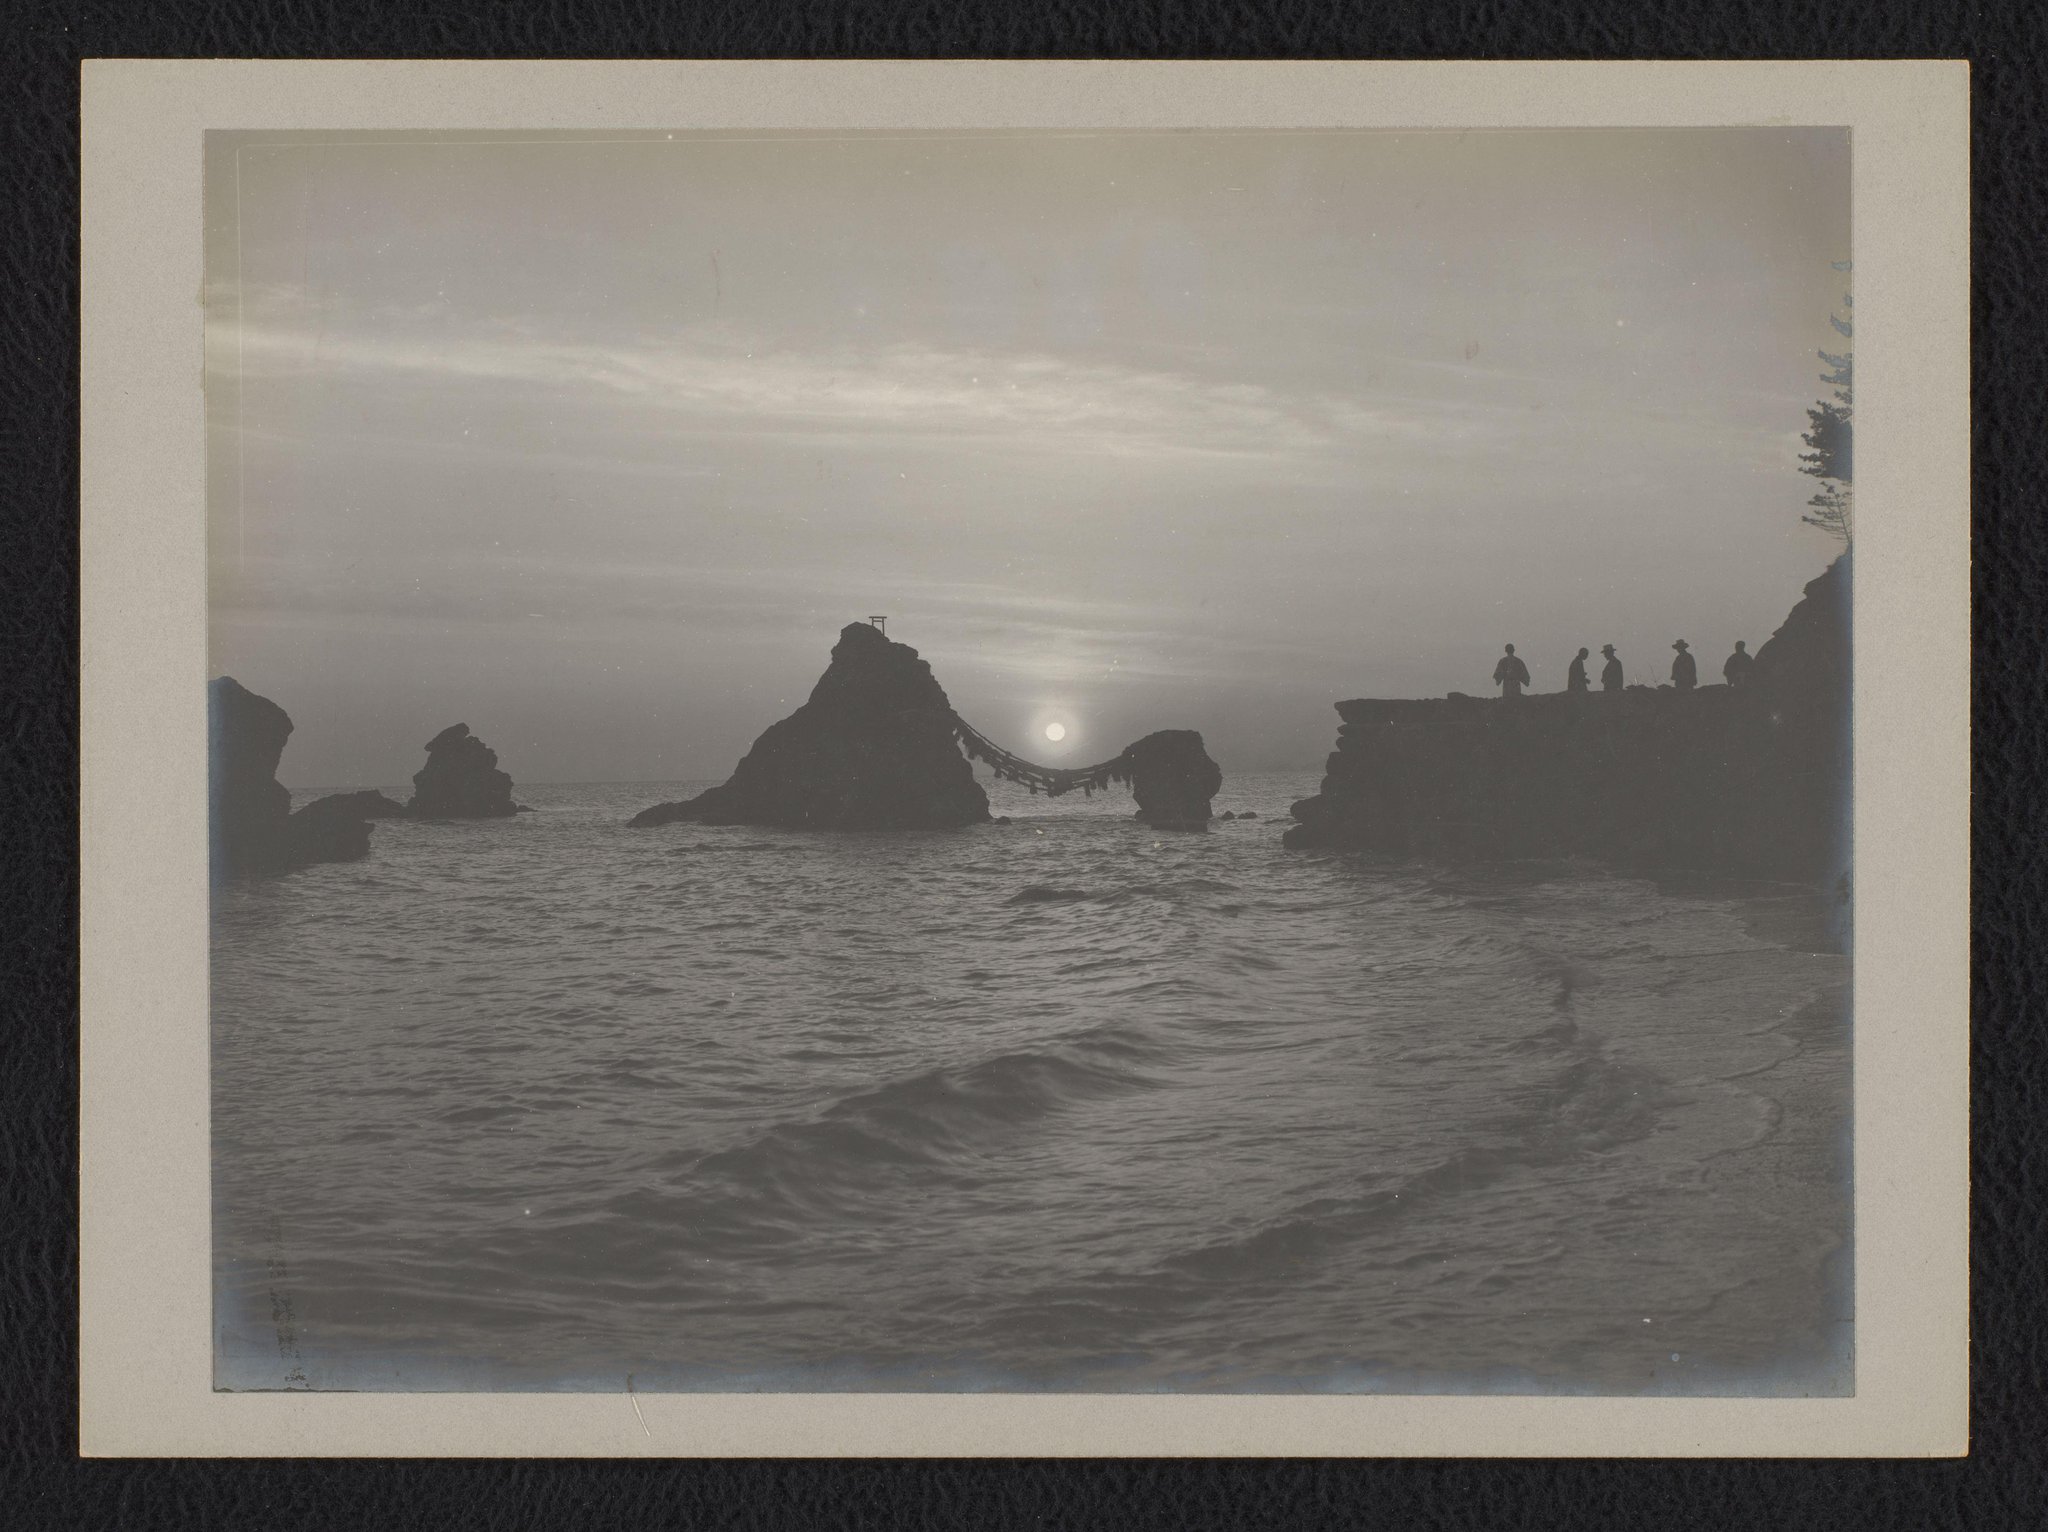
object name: photograph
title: Uitzicht op rotsen in zee bij ondergaande zon, Ise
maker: Anonymous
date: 1895-1915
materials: cardboard, photographic support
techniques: gelatin silver print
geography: ise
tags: ise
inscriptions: annotation: ‘15. Husband and wife; Isé.’